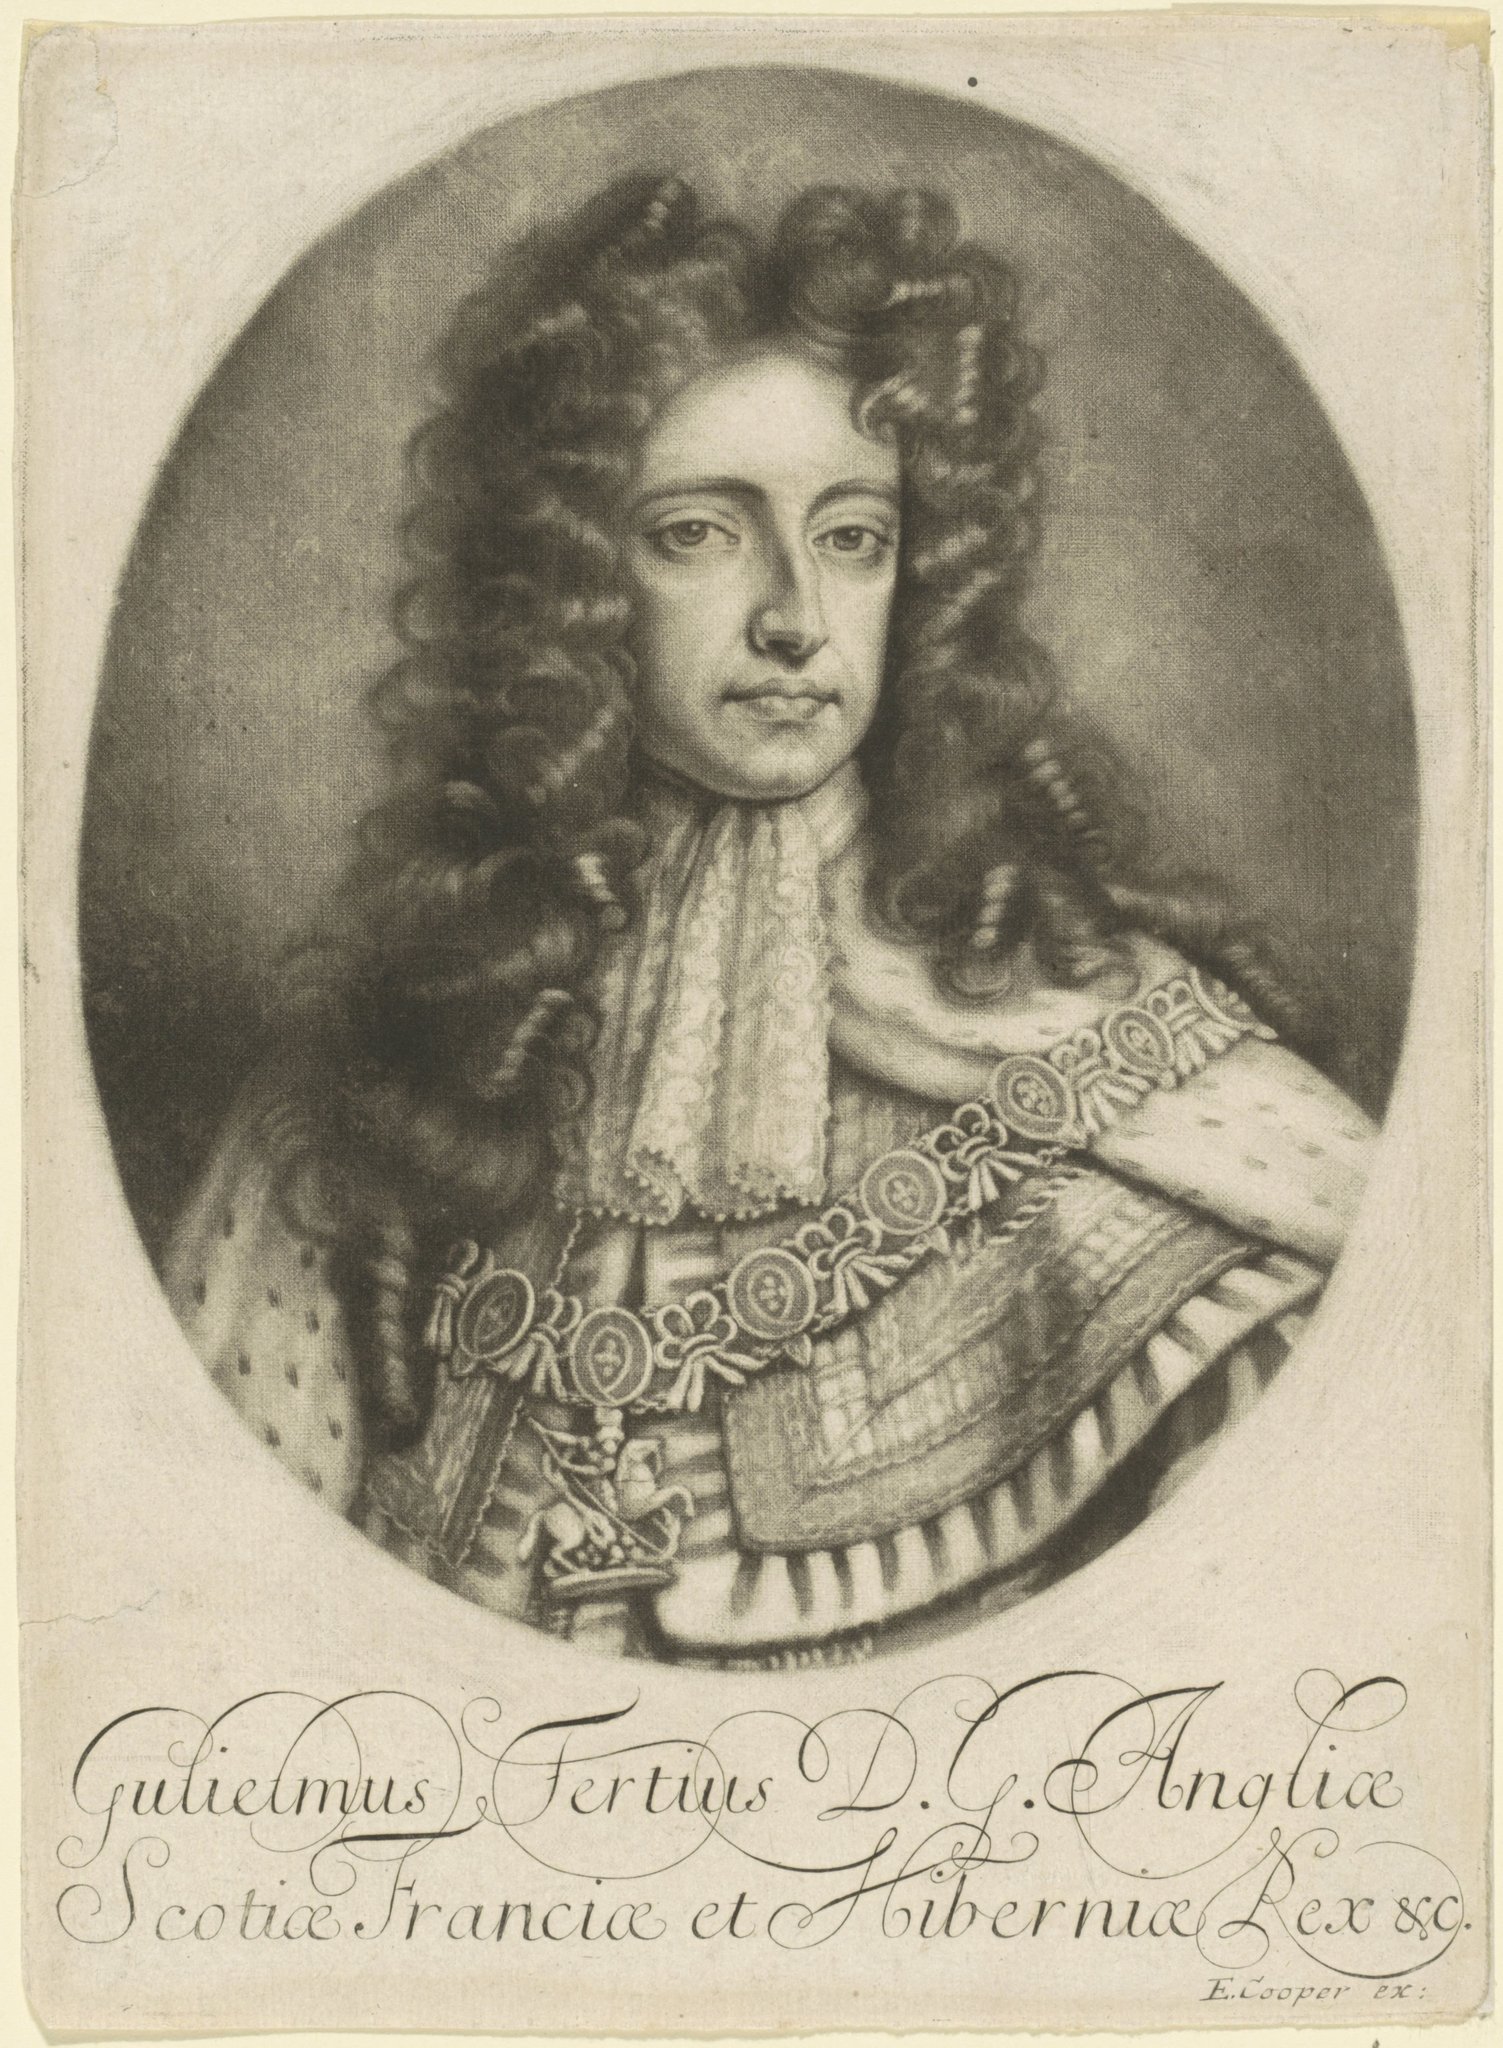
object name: print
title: Portret van Willem III, prins van Oranje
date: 1688-1725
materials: paper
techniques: mezzotint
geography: london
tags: the hague, william iii (prince of orange and king of england, scotland, and ireland), knighthood order (garter) - insignia of a knighthood order, e.g.: badge, chain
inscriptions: collector's mark: Lugt 963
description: De hier vermelde titel verwijst naar de hoogst verkregen titel van de geportretteerde, niet per se naar de titel die de geportretteerde op deze voorstelling draagt.